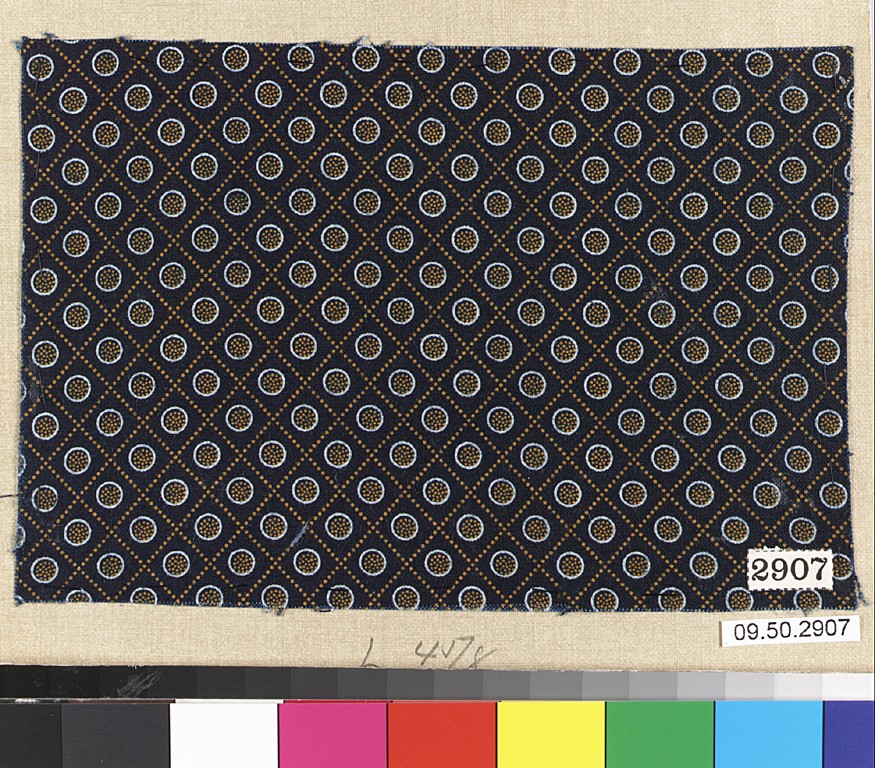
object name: piece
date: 1801-1900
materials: cotton